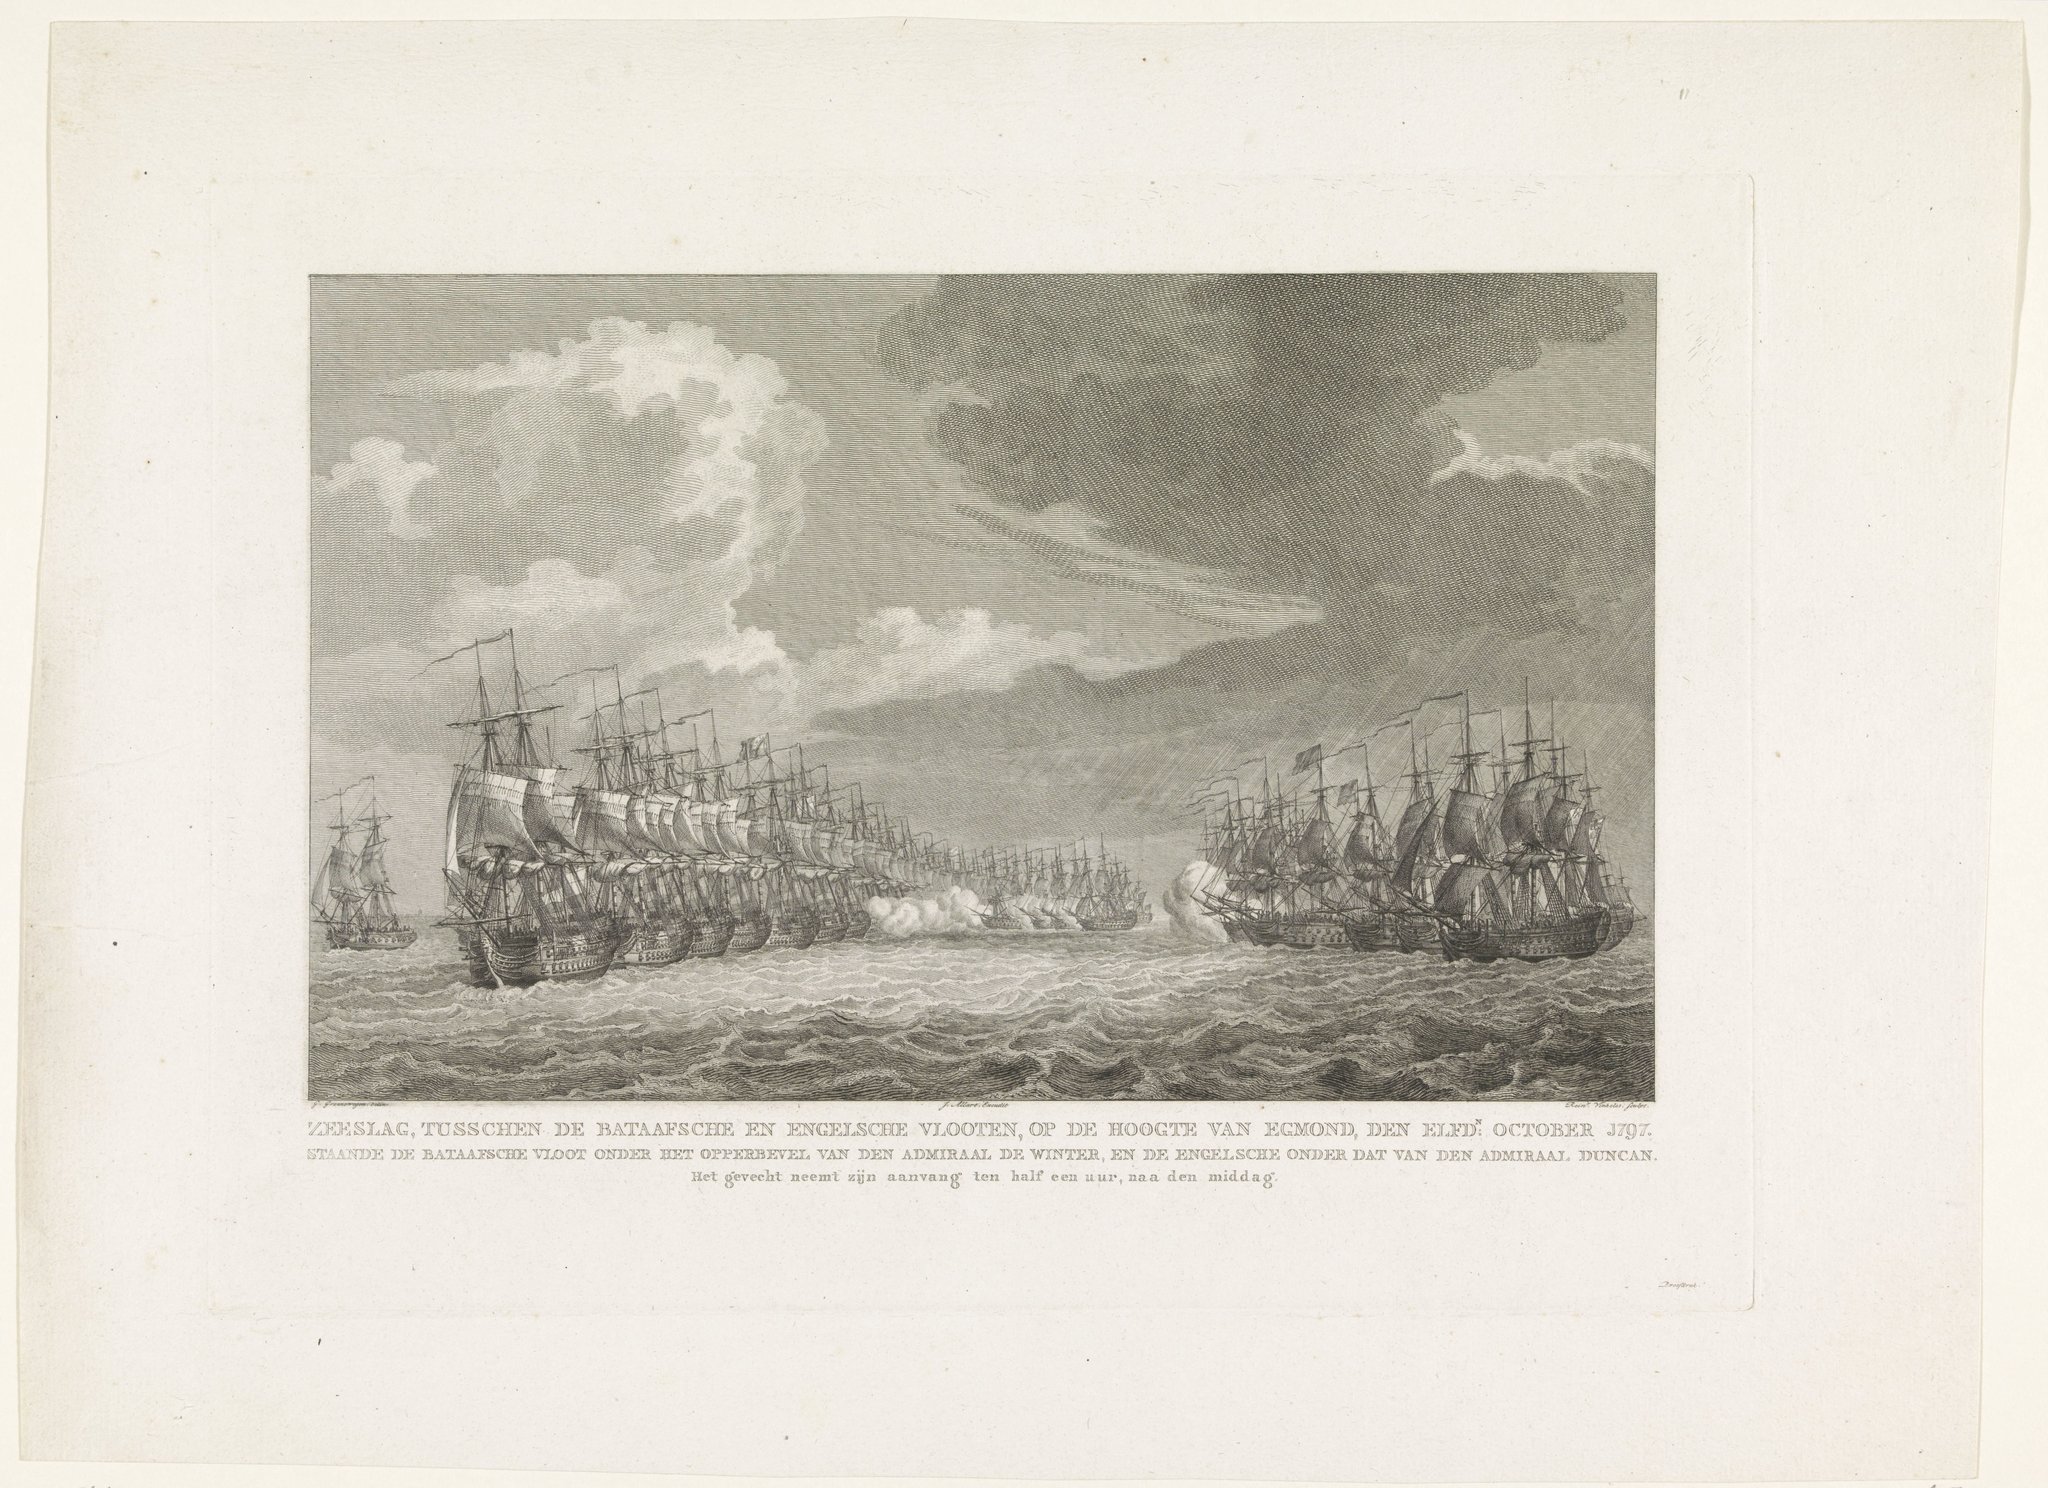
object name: print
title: Zeeslag, tusschen de Bataafsche en Engelsche Vlooten, op de hoogte van Egmond, den elfd.n october 1797 (...) Het gevecht neemt zijn aanvang ten half een uur , naa den middag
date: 1798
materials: paper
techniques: engraving, etching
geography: amsterdam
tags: jan willem de winter, battle (+ naval force), battle of camperdown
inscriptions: collector's mark: Lugt 2228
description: De Zeeslag bij Kamperduin op 11 oktober 1797 tussen de Bataafse vloot onder bevel van viceadmiraal Jan Willem de Winter en een Britse vloot onder admiraal Adam Duncan. Aanvang van de slag met links de Bataafse vloot in line met de schepen de Gelijkheid en de Vrijheid (dit schip onder bevel van De Winter); rechts de Engelse schepen in linie, onder bevel van viceadmiraal Onslow en admiraal Duncan. Vóór de legenda 1-4.